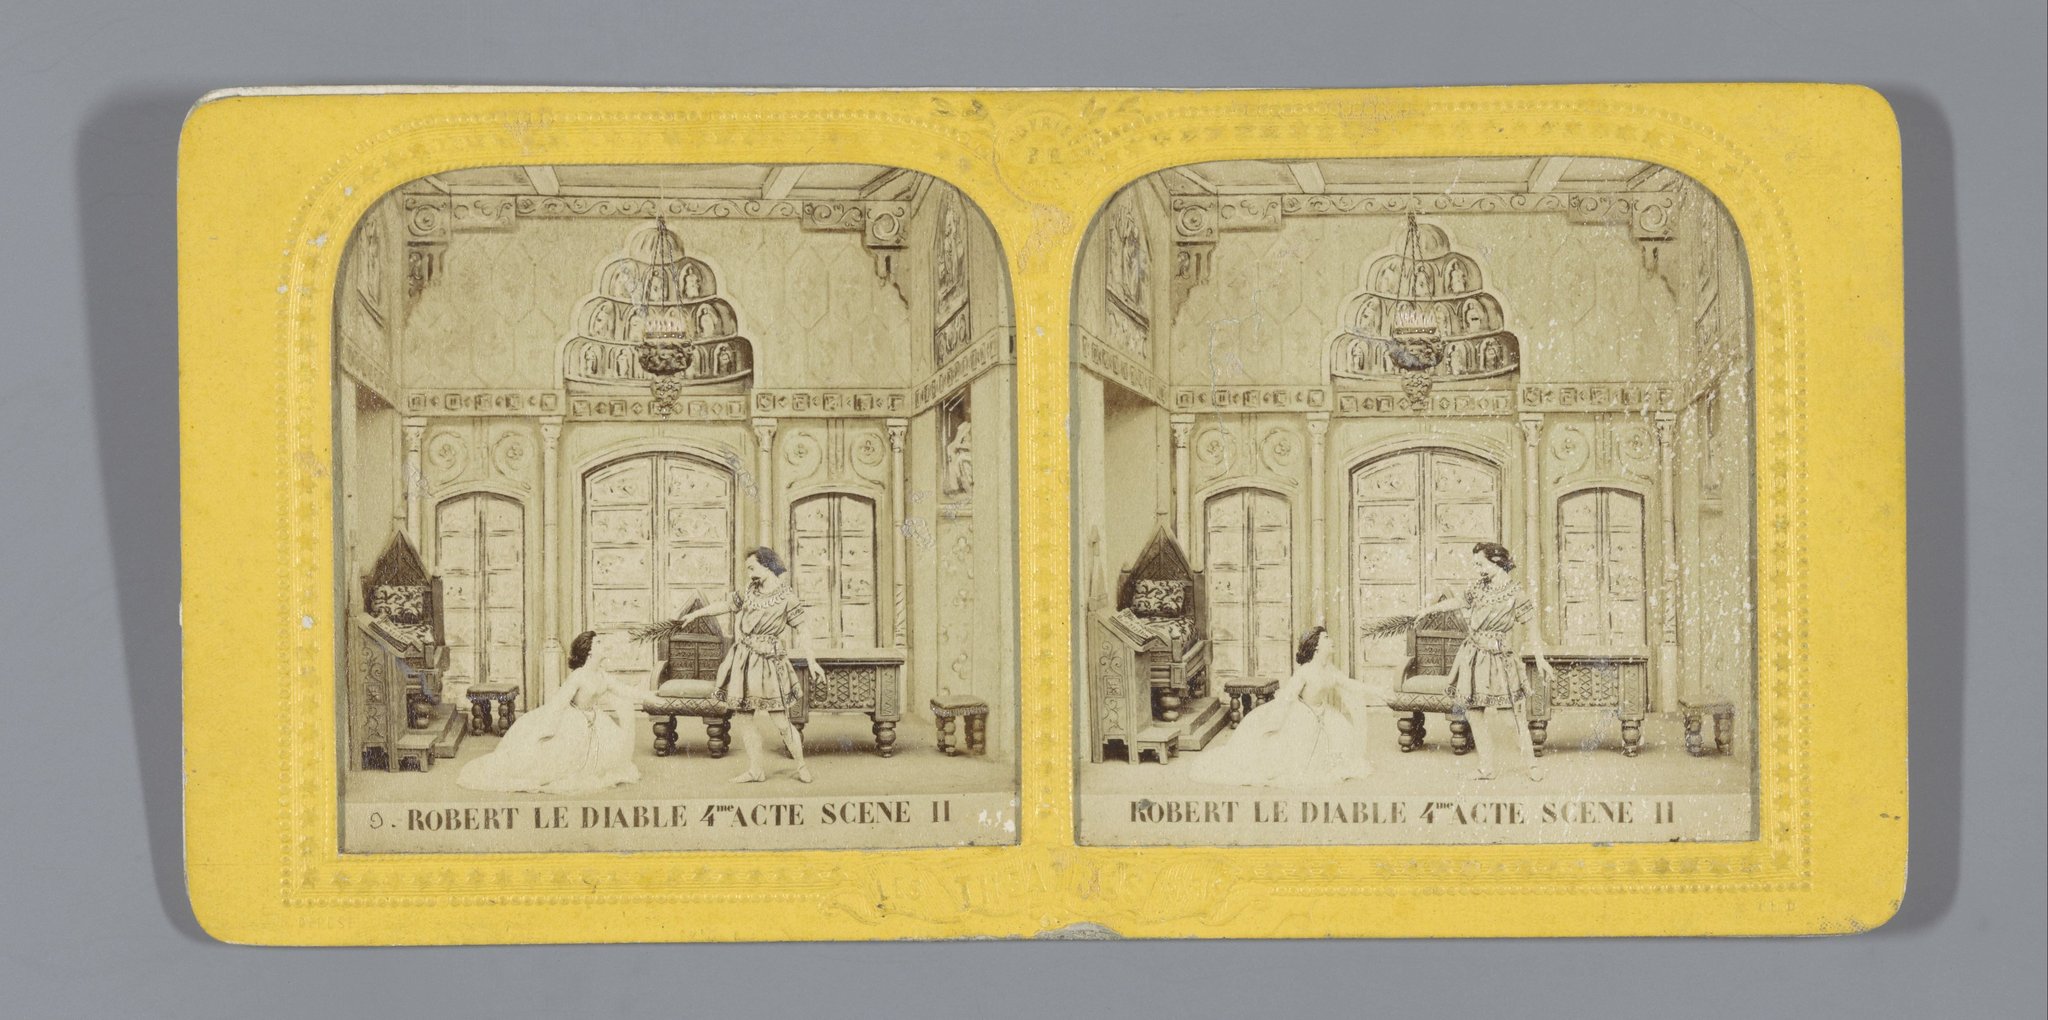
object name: tissue stereograph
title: Robert le Diable, 4me acte, scene II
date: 1873-1874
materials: cardboard, paper, photographic support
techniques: albumen print, hand coloring, perforating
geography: paris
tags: opera, paris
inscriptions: inscription: ‘Toutes les épreuves non revêtues du timbre ci-contre/ seront considérées comme contrefacon, le Dépôt/ ayant été fait en France selon la loi et à l' Etranger/ conformément aux conventions internationales./ PROPRIÉTÉ/ B.K./ PARIS’, inscription: ‘DÉPOSÉ/ Ch D’, number: ‘9.’